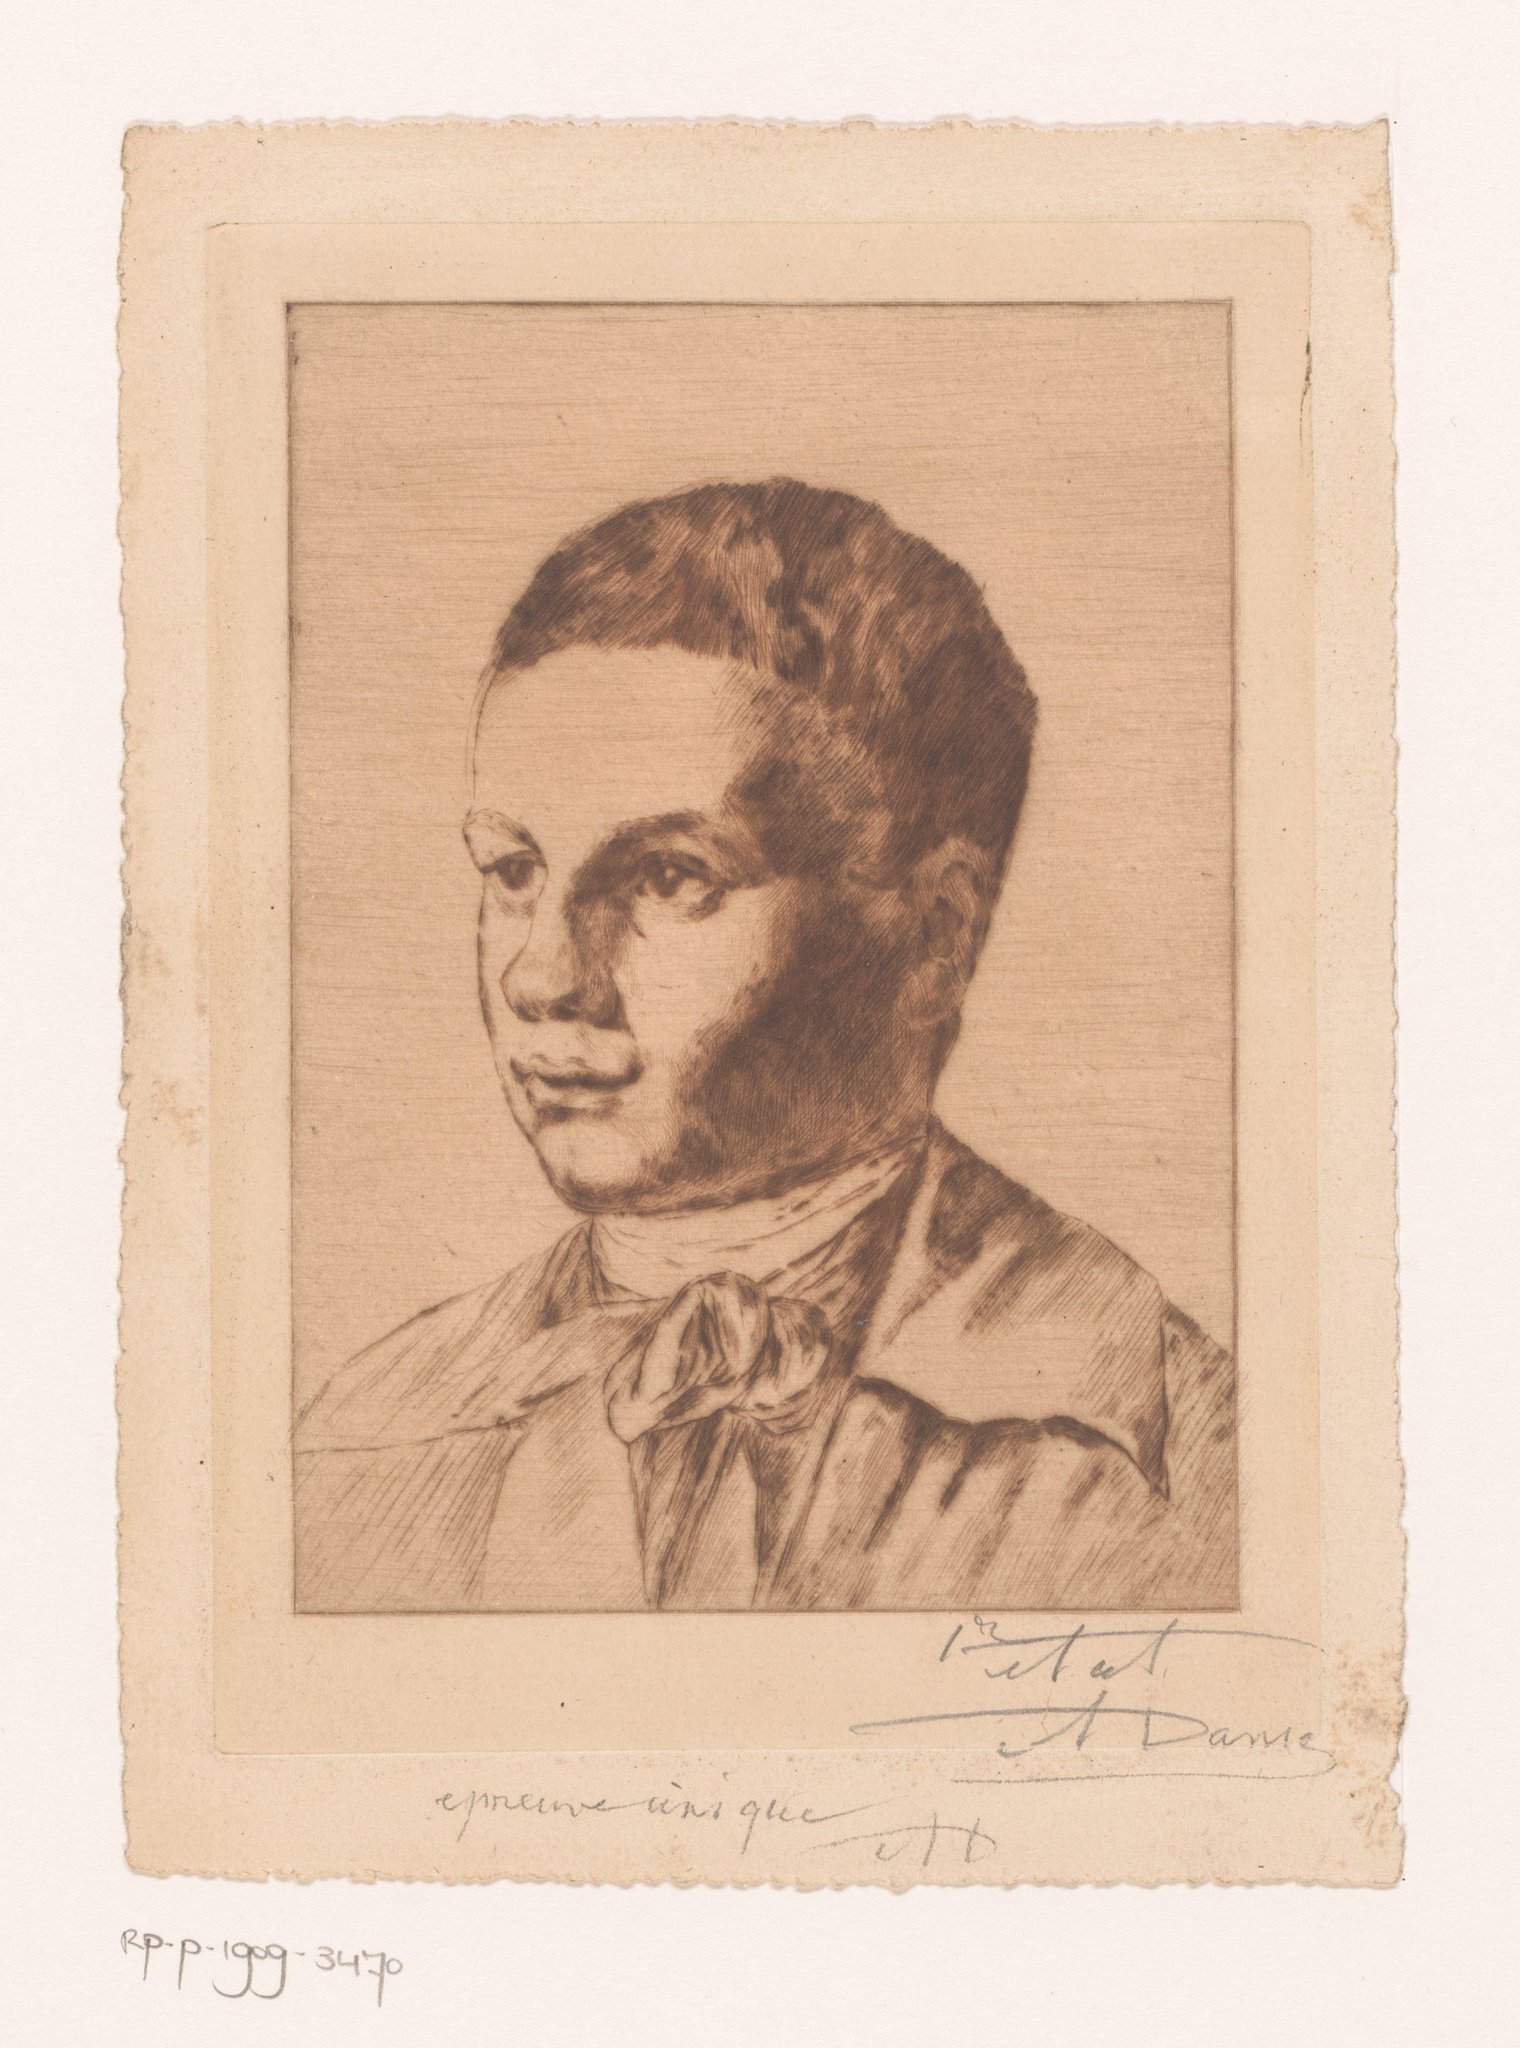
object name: print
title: Zelfportret op zestienjarige leeftijd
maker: auguste danse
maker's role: print maker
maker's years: 1829-1929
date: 1839-1909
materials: paper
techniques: drypoint, etching, intaglio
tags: brussels, print maker, auguste danse, portrait, self-portrait of artist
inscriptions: annotation: ‘1er état; epreuve unique’, collector's mark: Lugt 2228